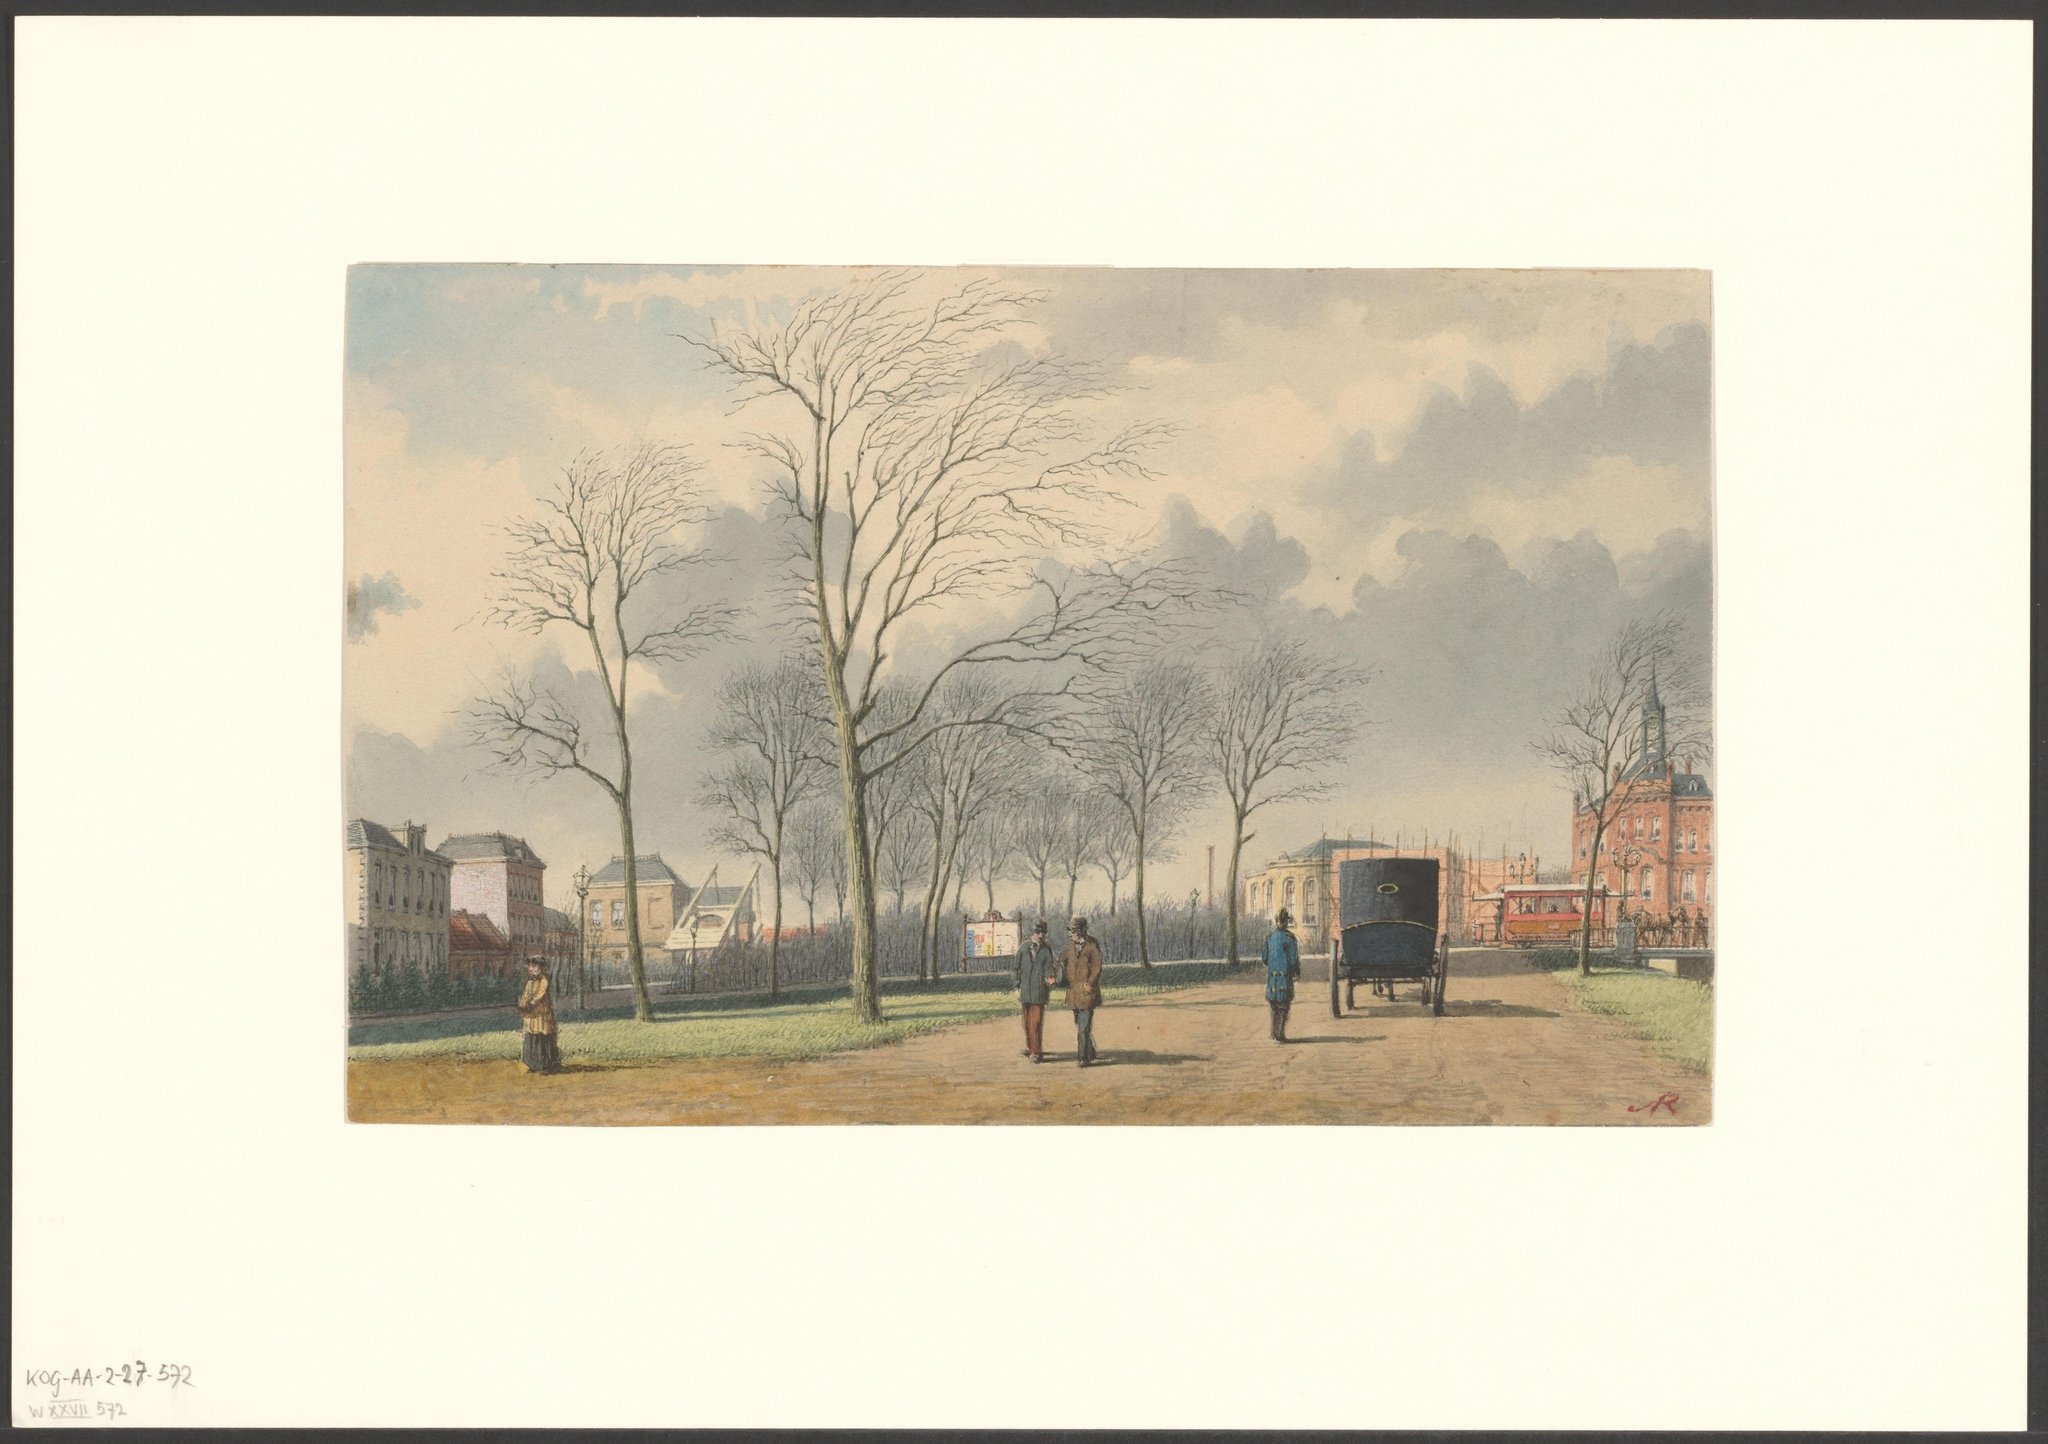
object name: drawing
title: Gezicht op het Leidsebosje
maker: johan martinus anthon rieke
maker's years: 1851-1899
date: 1861-1899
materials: gouache, ink, paper, pencil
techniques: brush, pen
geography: amsterdam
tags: city-view in general; 'veduta', public gardens, park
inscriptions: signature: ‘JR’, inscription: ‘Laatste overblijfzelen van het Leidsche bosch / J M A. Rieke fec.’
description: Tekening binnen de Atlas Van Eck ingedeeld op wijknummer 27.